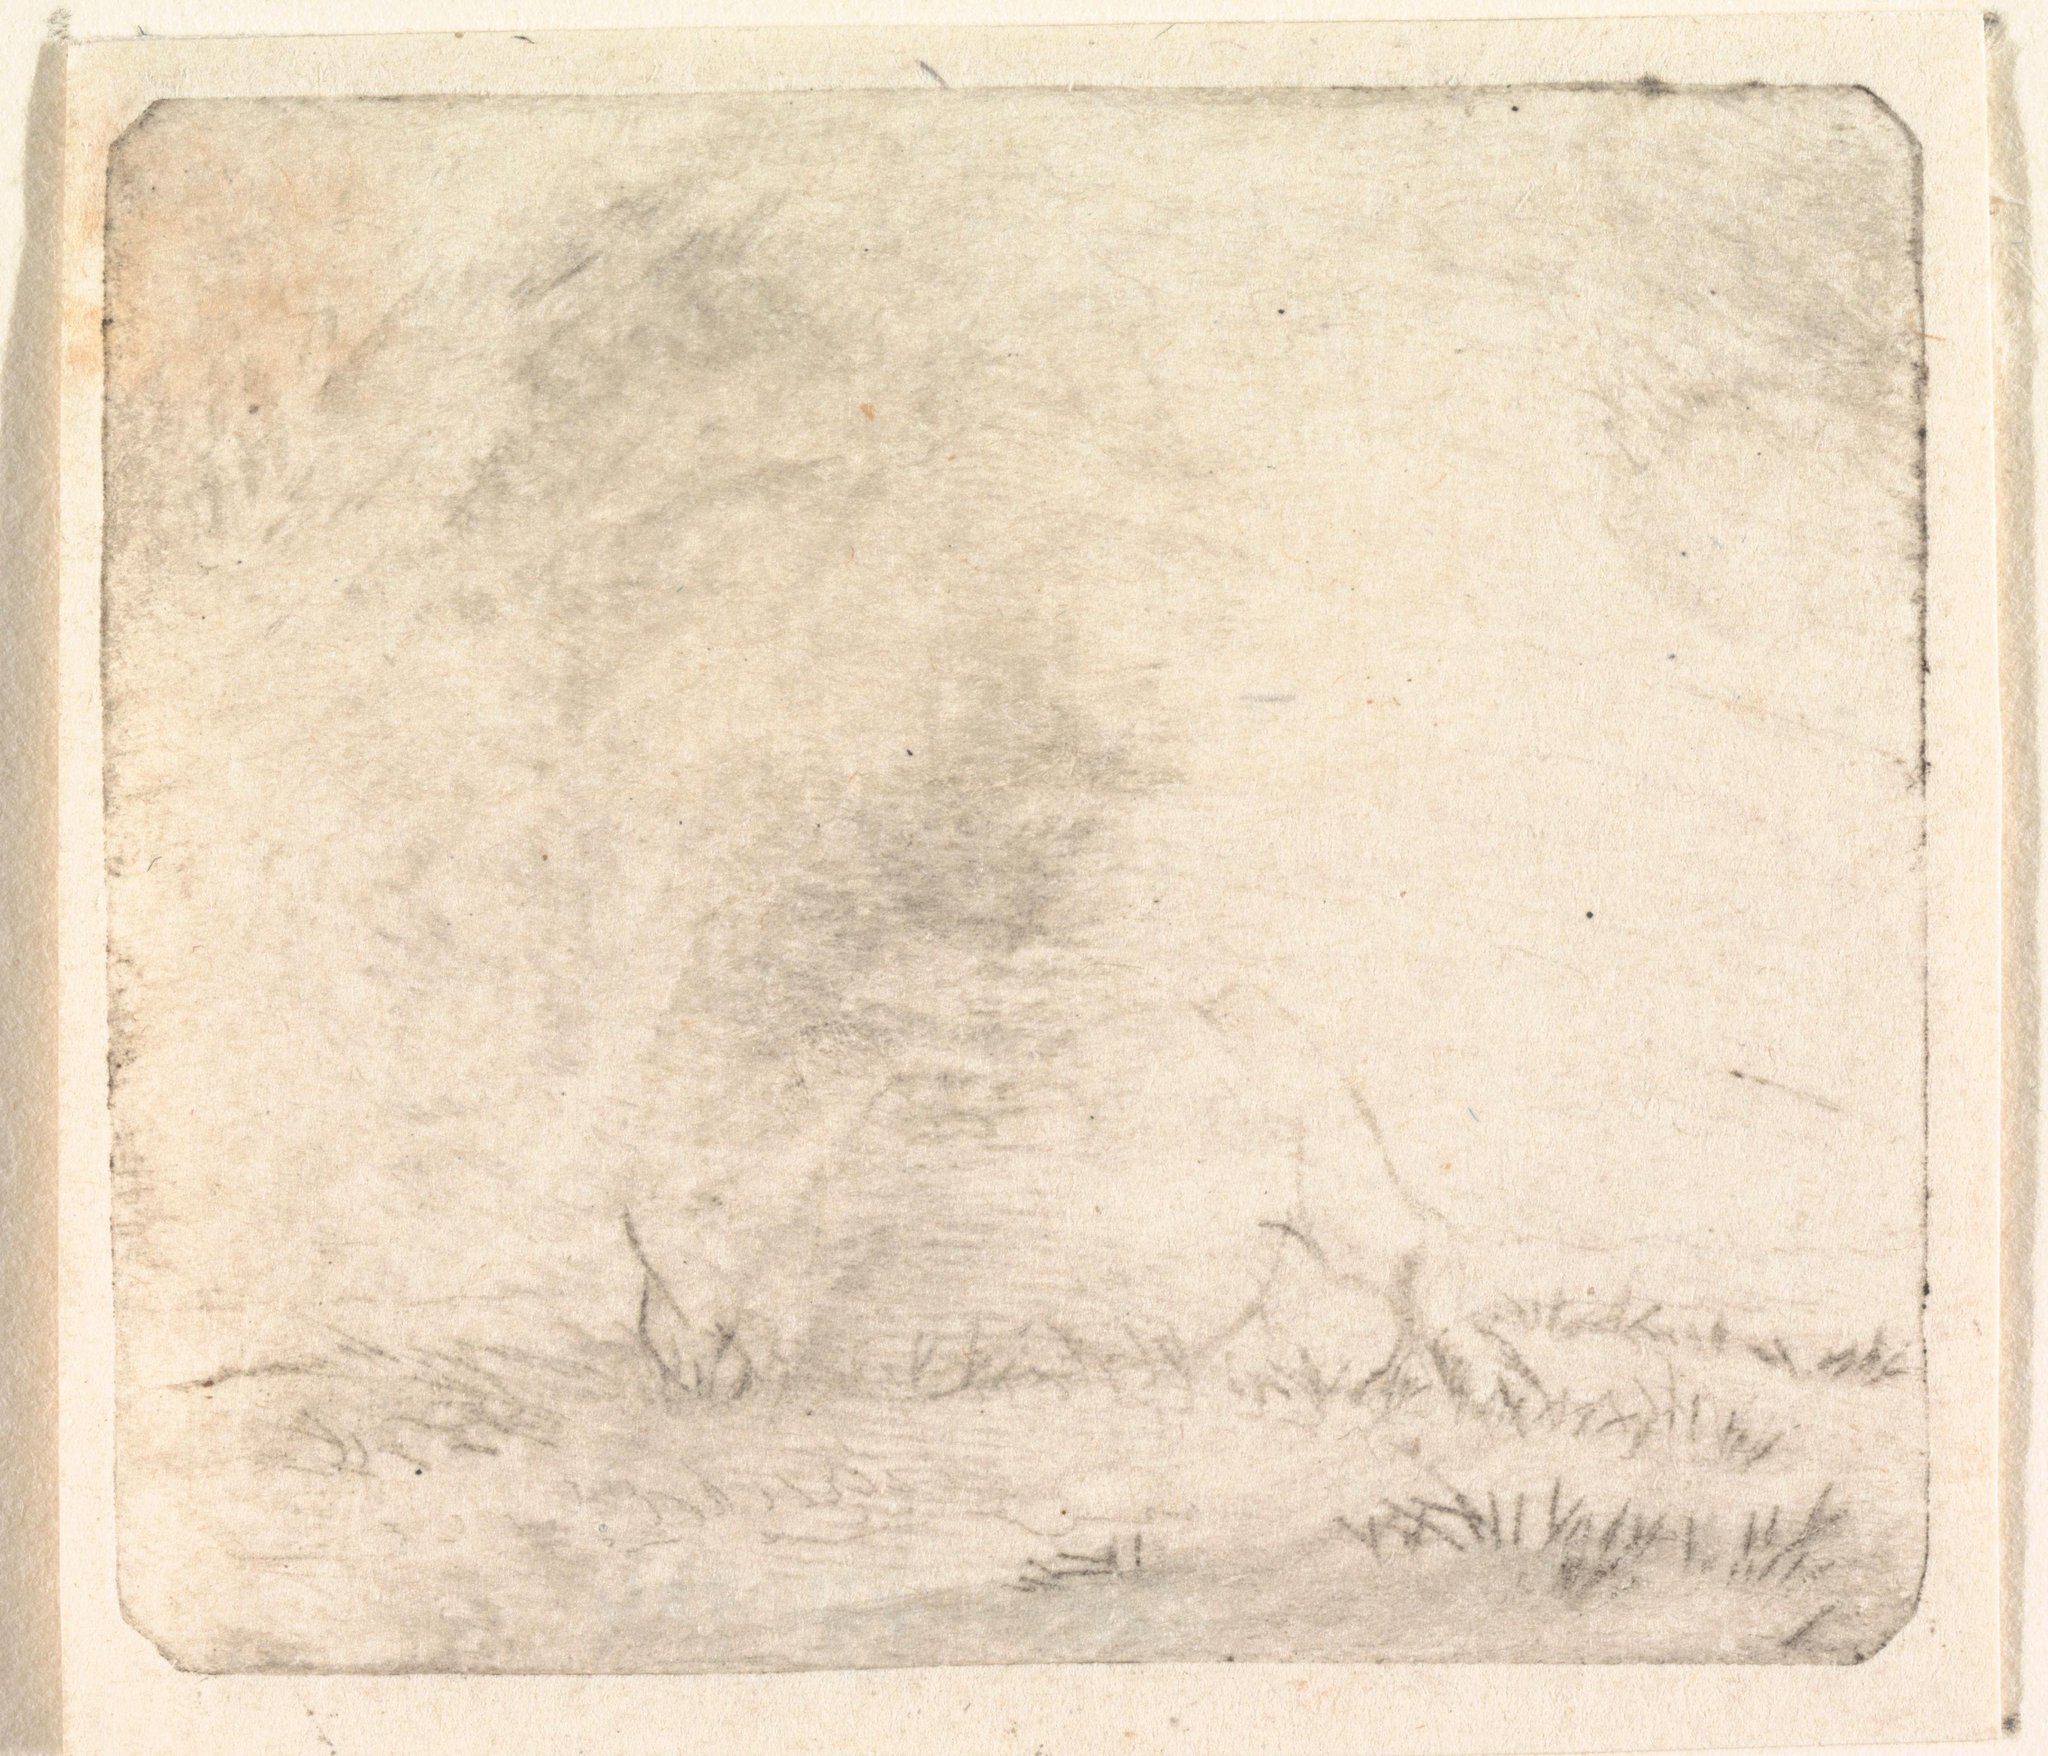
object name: print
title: Liggende koe, van voren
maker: pieter janson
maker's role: draughtsman, print maker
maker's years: 1765-1851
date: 1780-1851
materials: chalk, paper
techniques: etching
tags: cow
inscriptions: collector's mark: Lugt 240